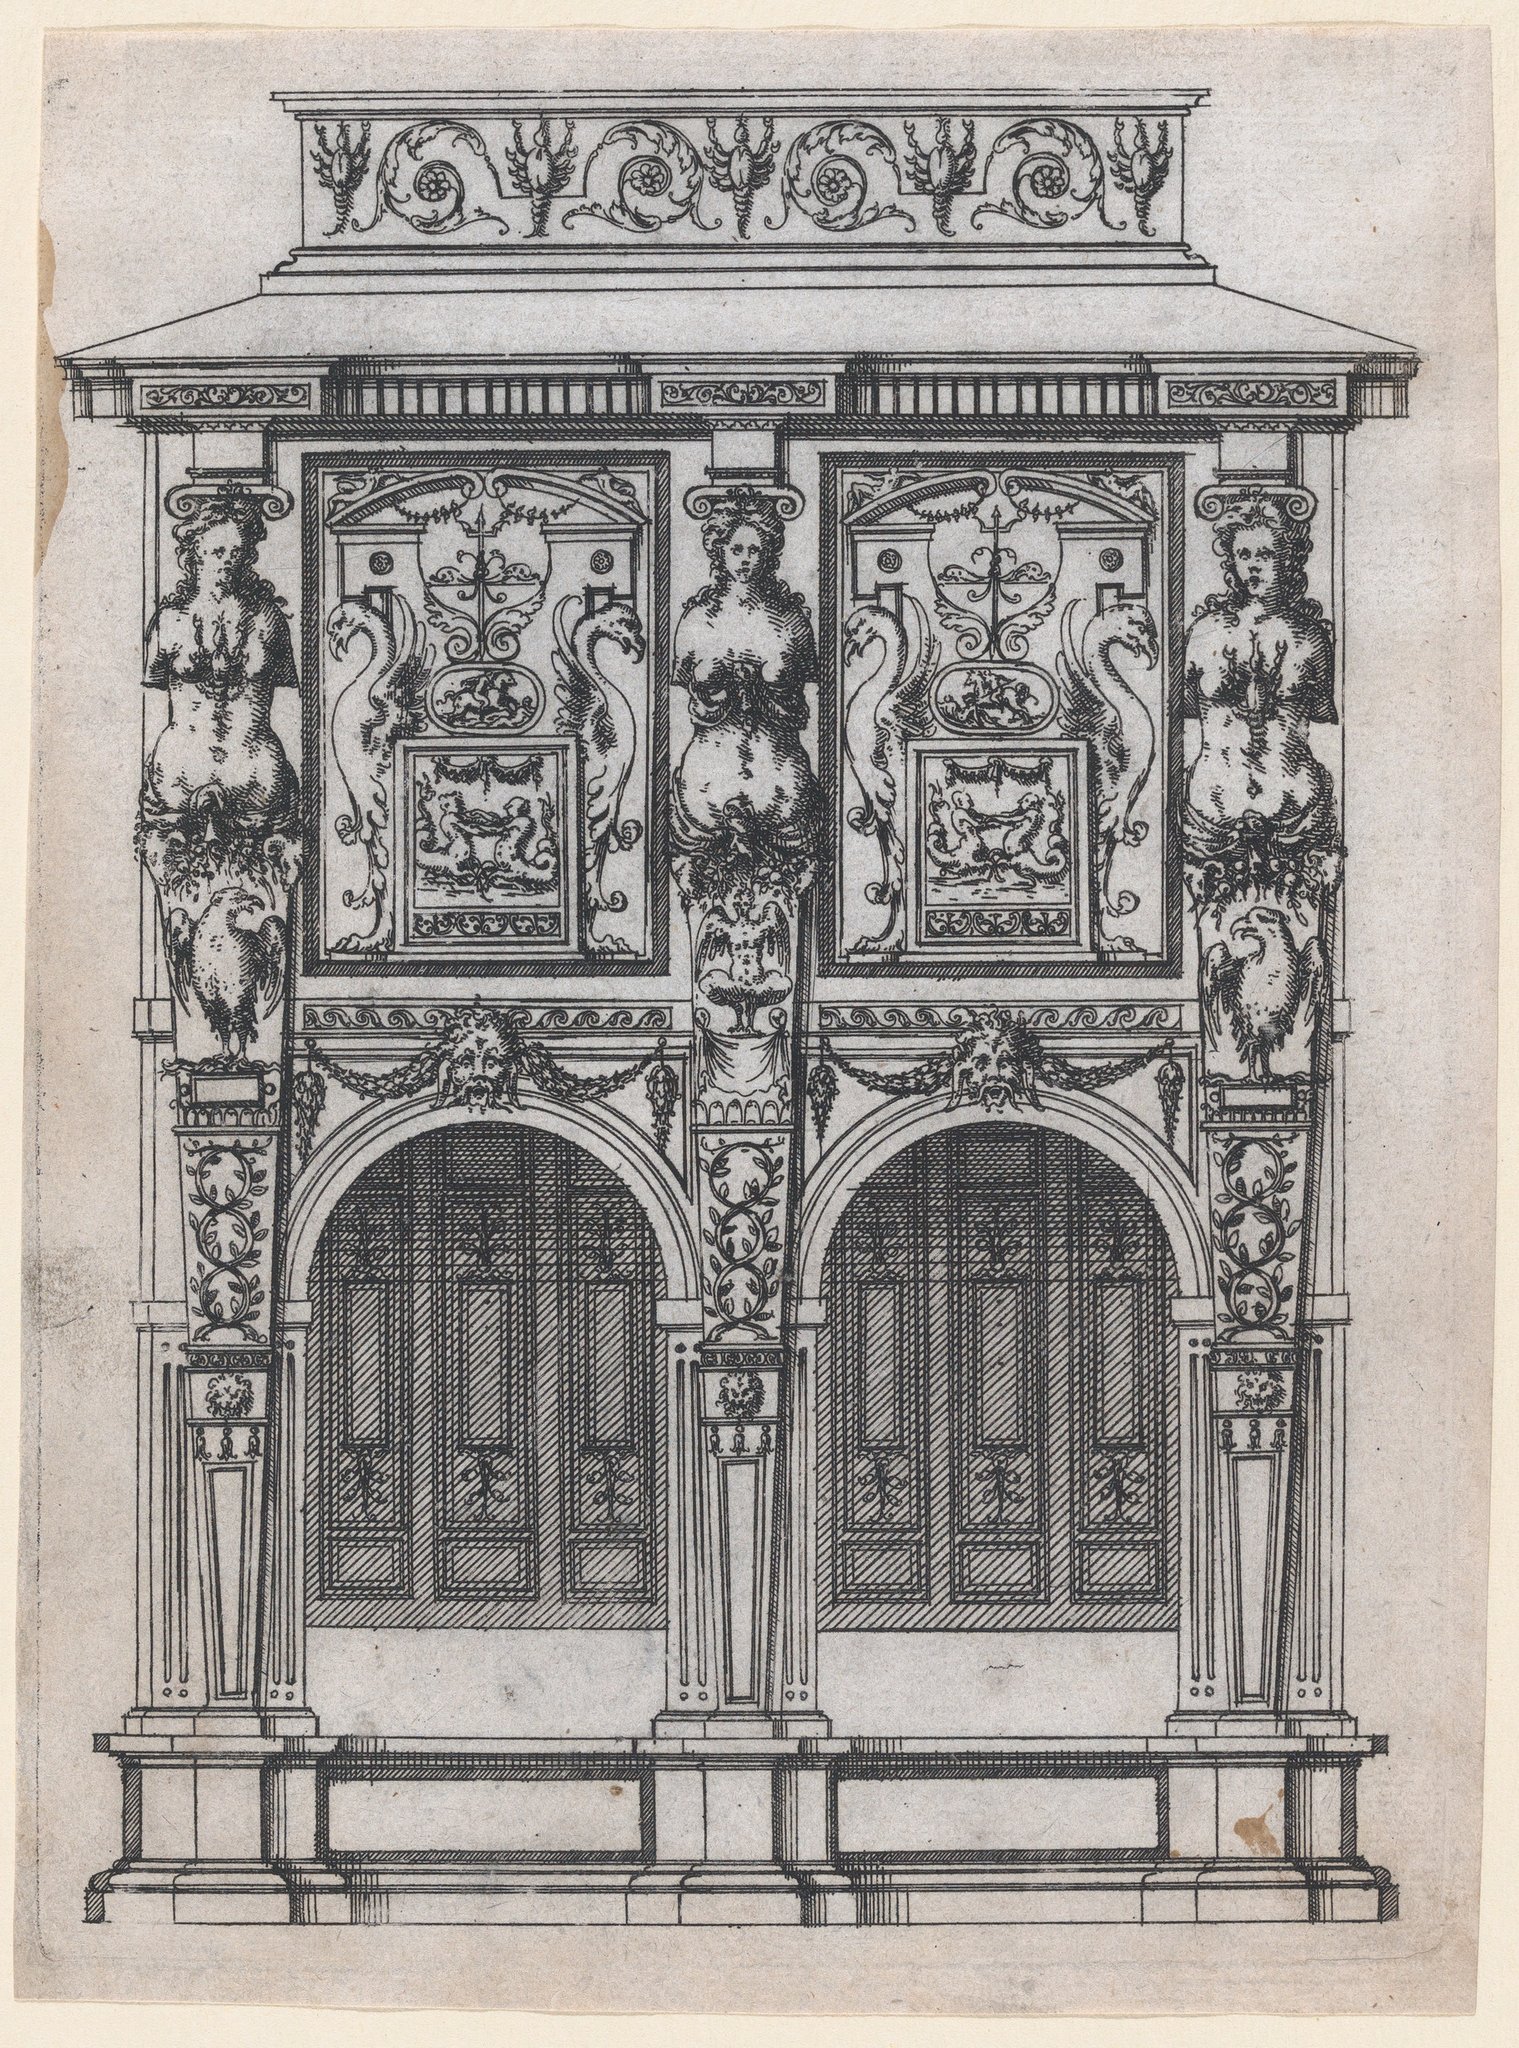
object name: print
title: Furniture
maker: jacques androuet du cerceau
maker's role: artist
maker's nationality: french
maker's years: 1510-1585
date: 1565-1570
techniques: etching